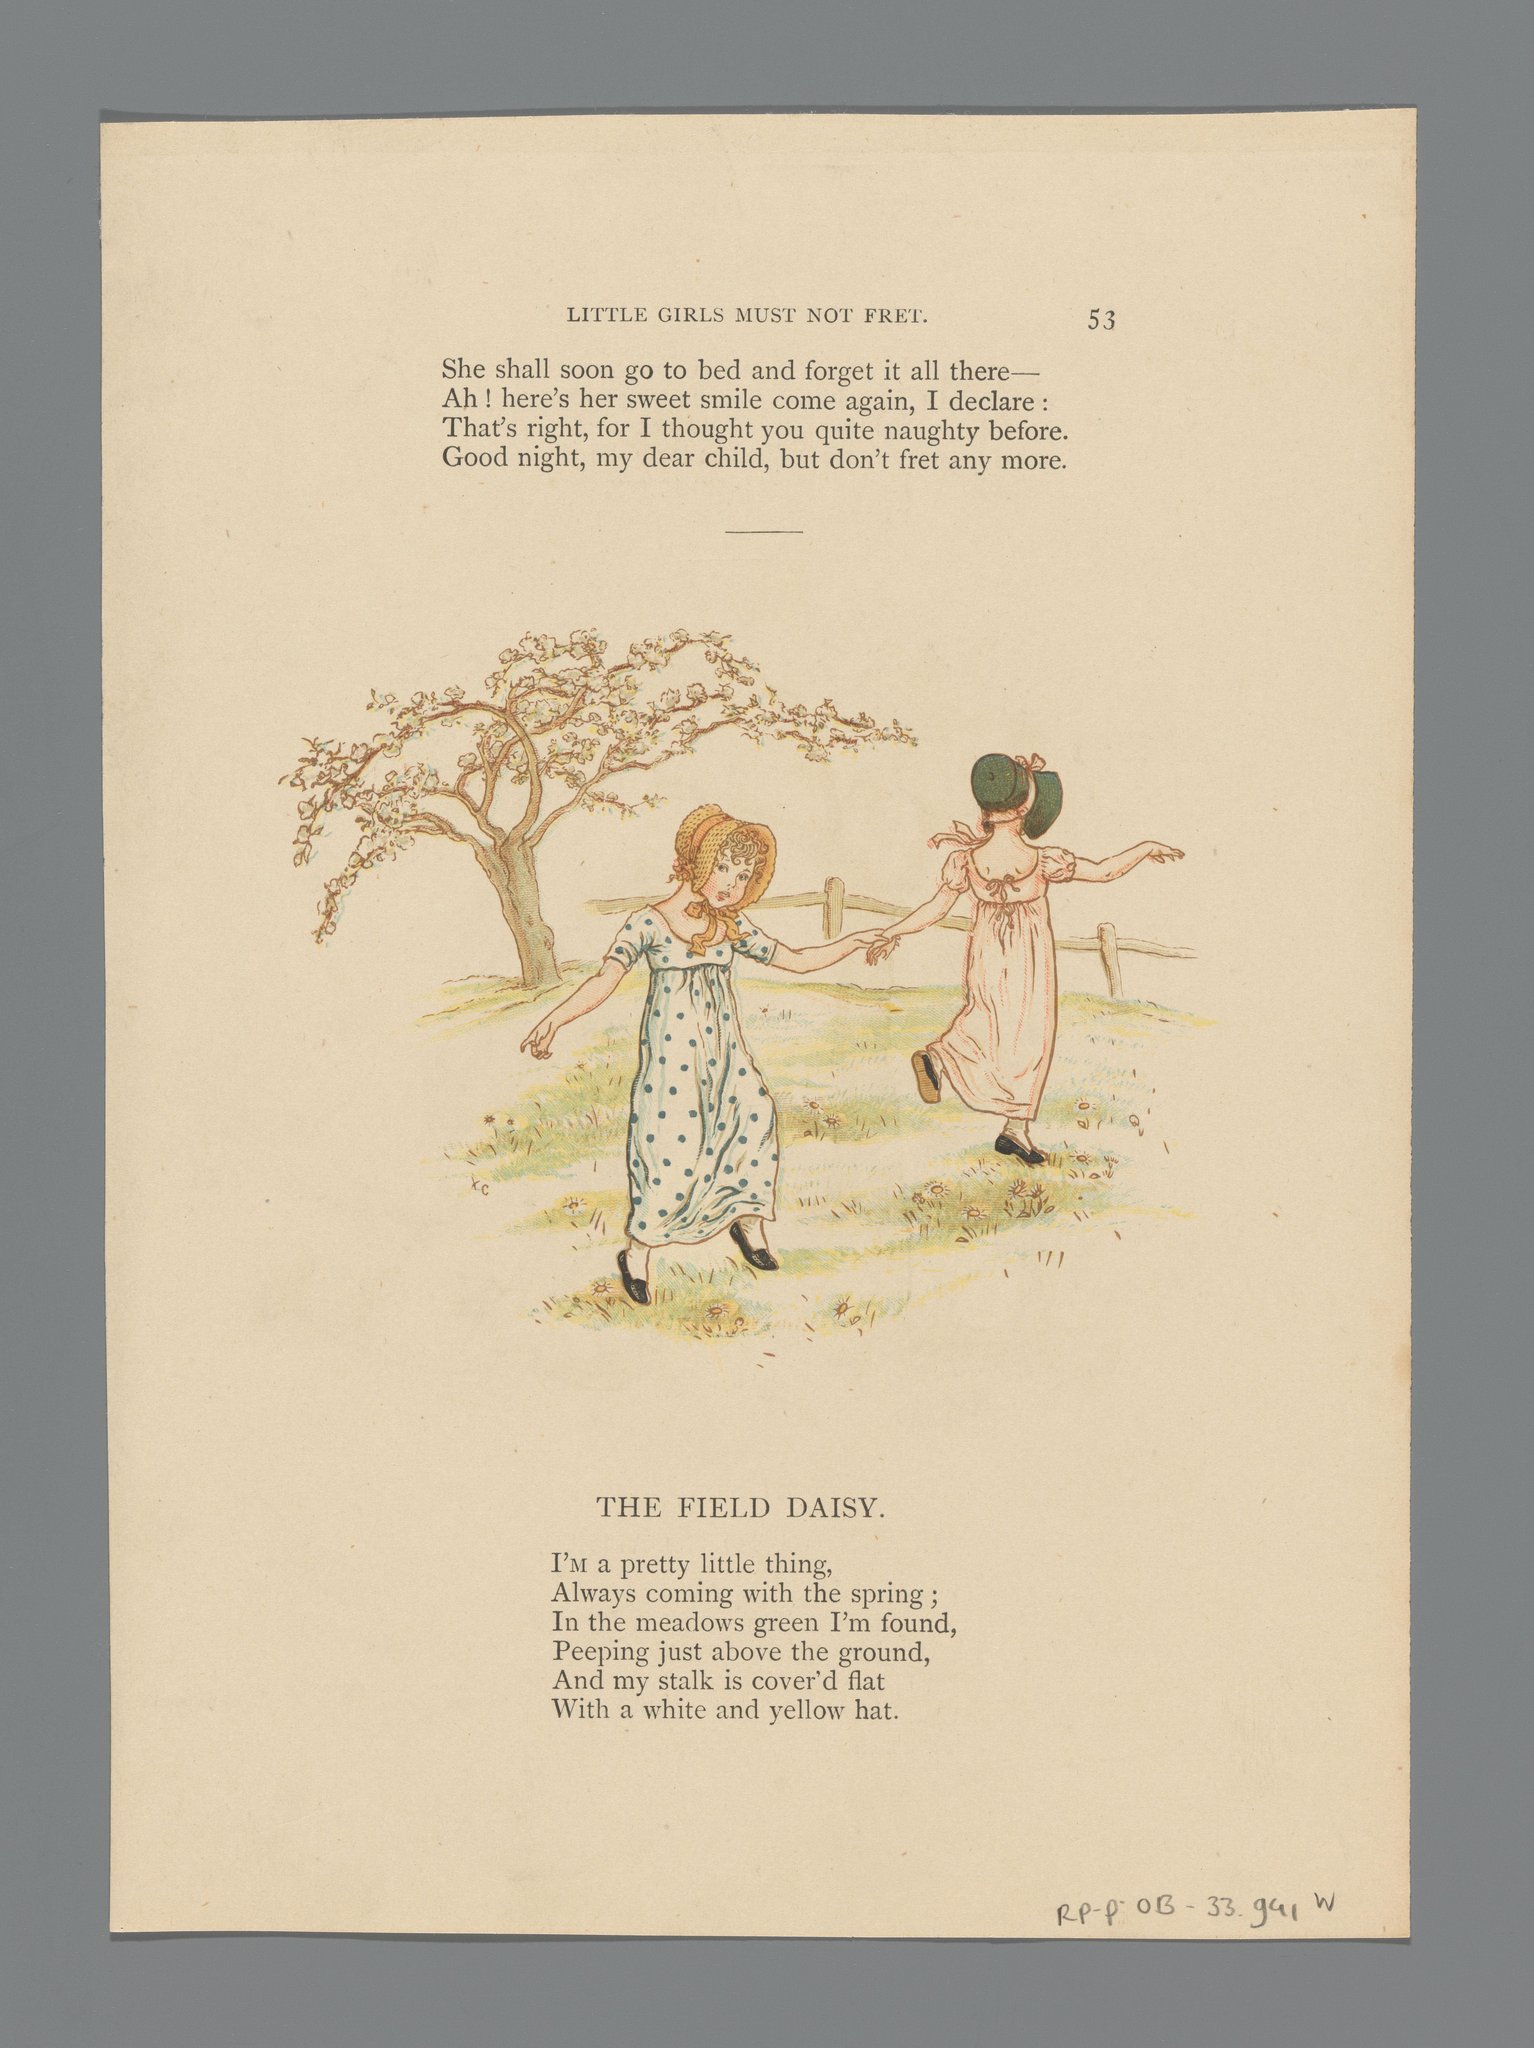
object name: print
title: Landschap met twee meisjes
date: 1883-1927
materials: paper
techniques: wood engraving, letterpress printing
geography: london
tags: trees, meadow, pasture, girl (child between toddler and youth) (+ two persons)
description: Prent uit: Jane en Ann Taylor. Little Ann and other poems. Londen: George Routledge & Sons, [1883], p. 53. Of een latere uitgave.